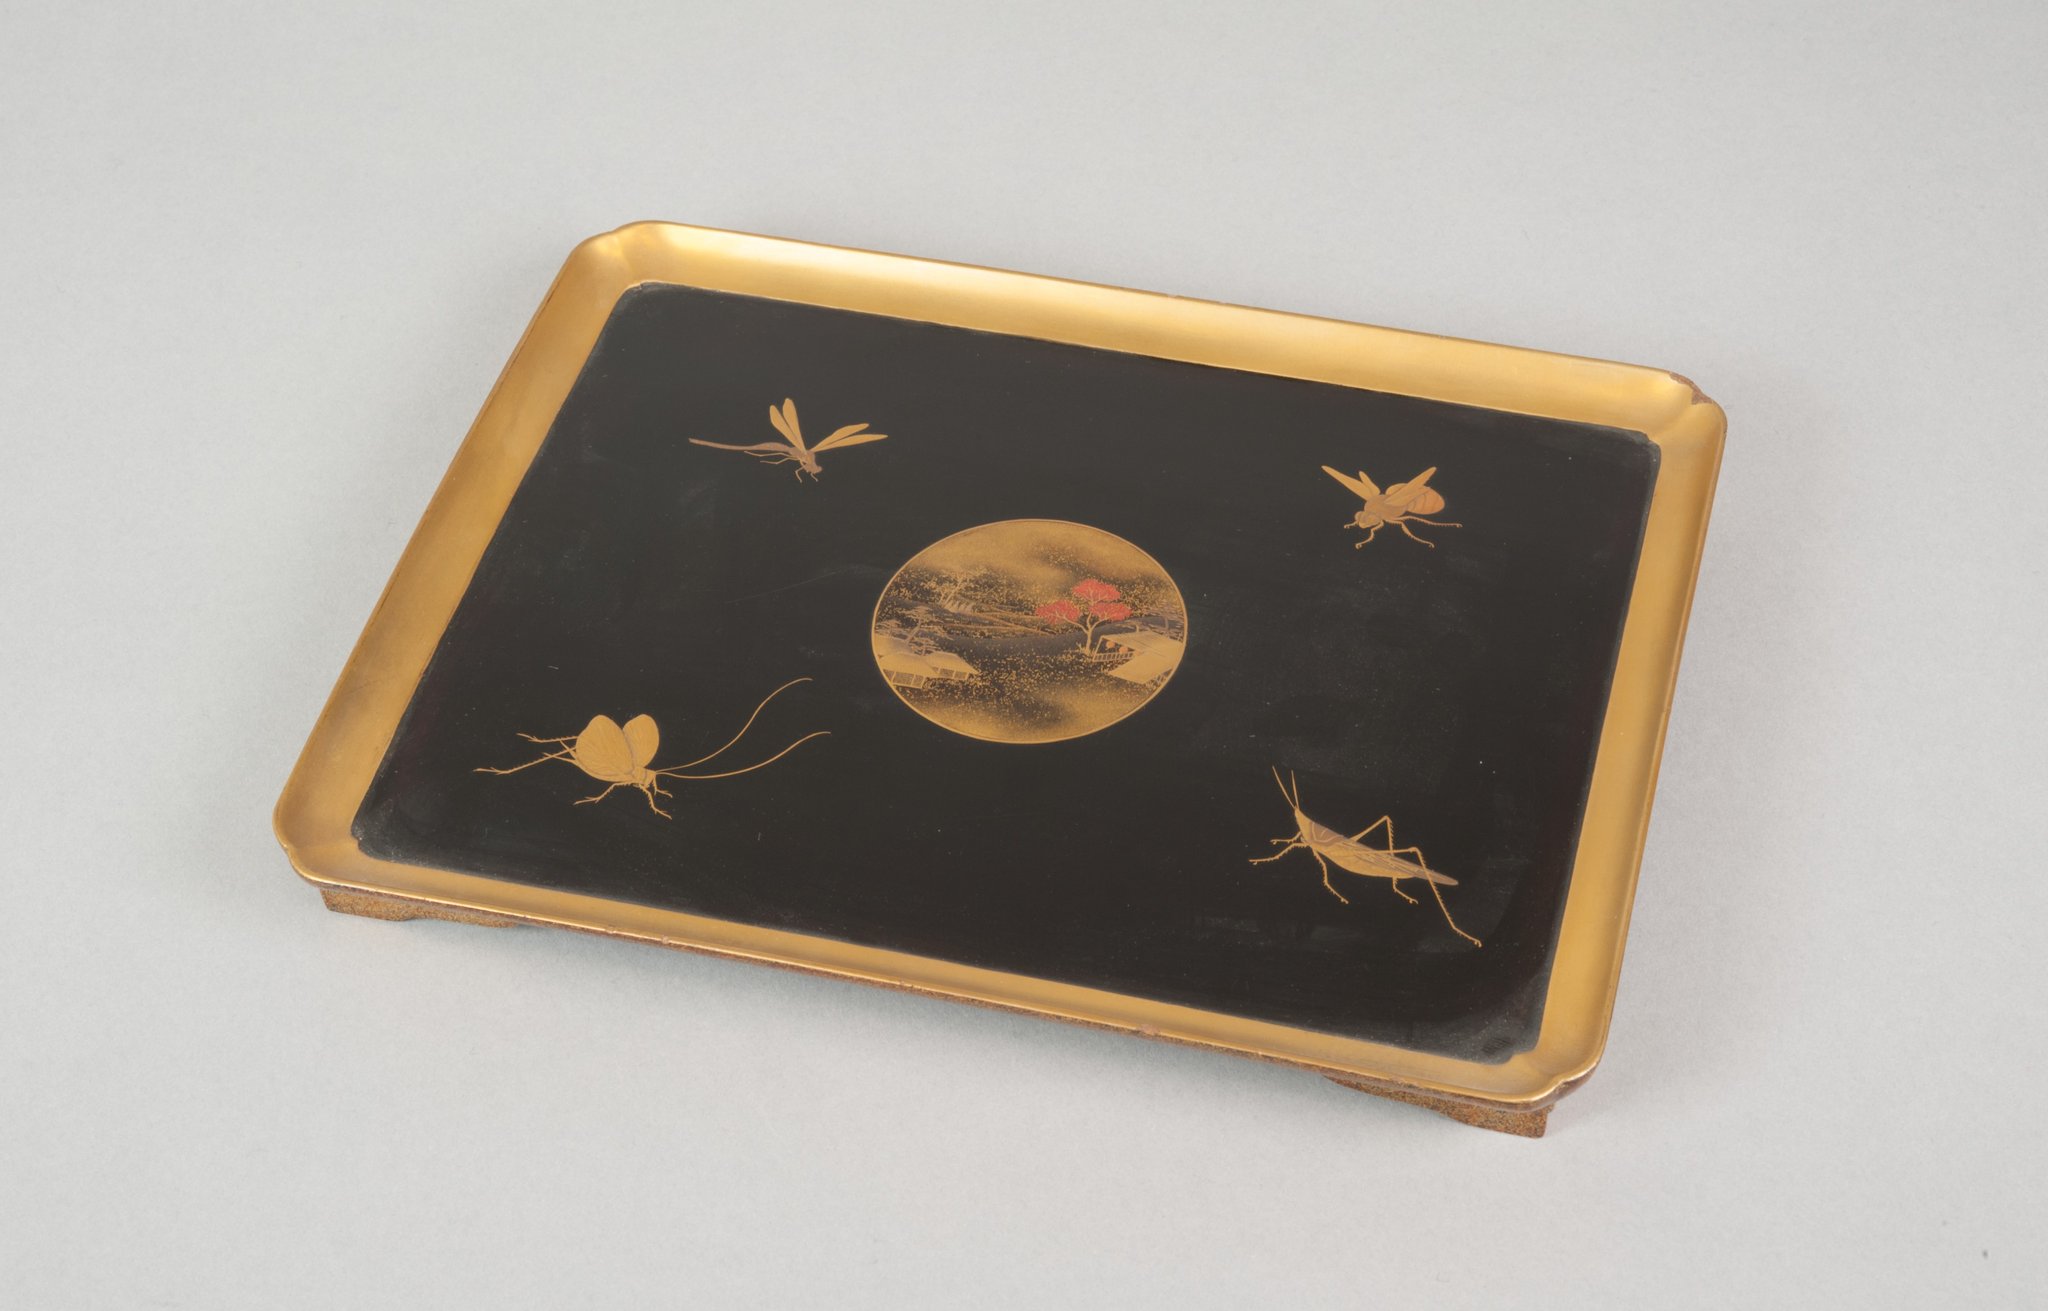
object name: tray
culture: japanese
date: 1801-1900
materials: lacquer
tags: insects